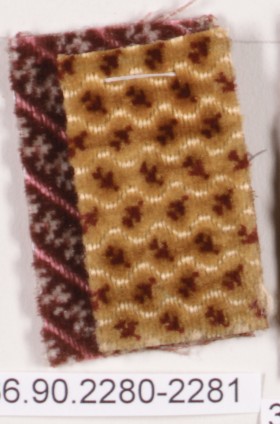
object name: piece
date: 1801-1900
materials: silk